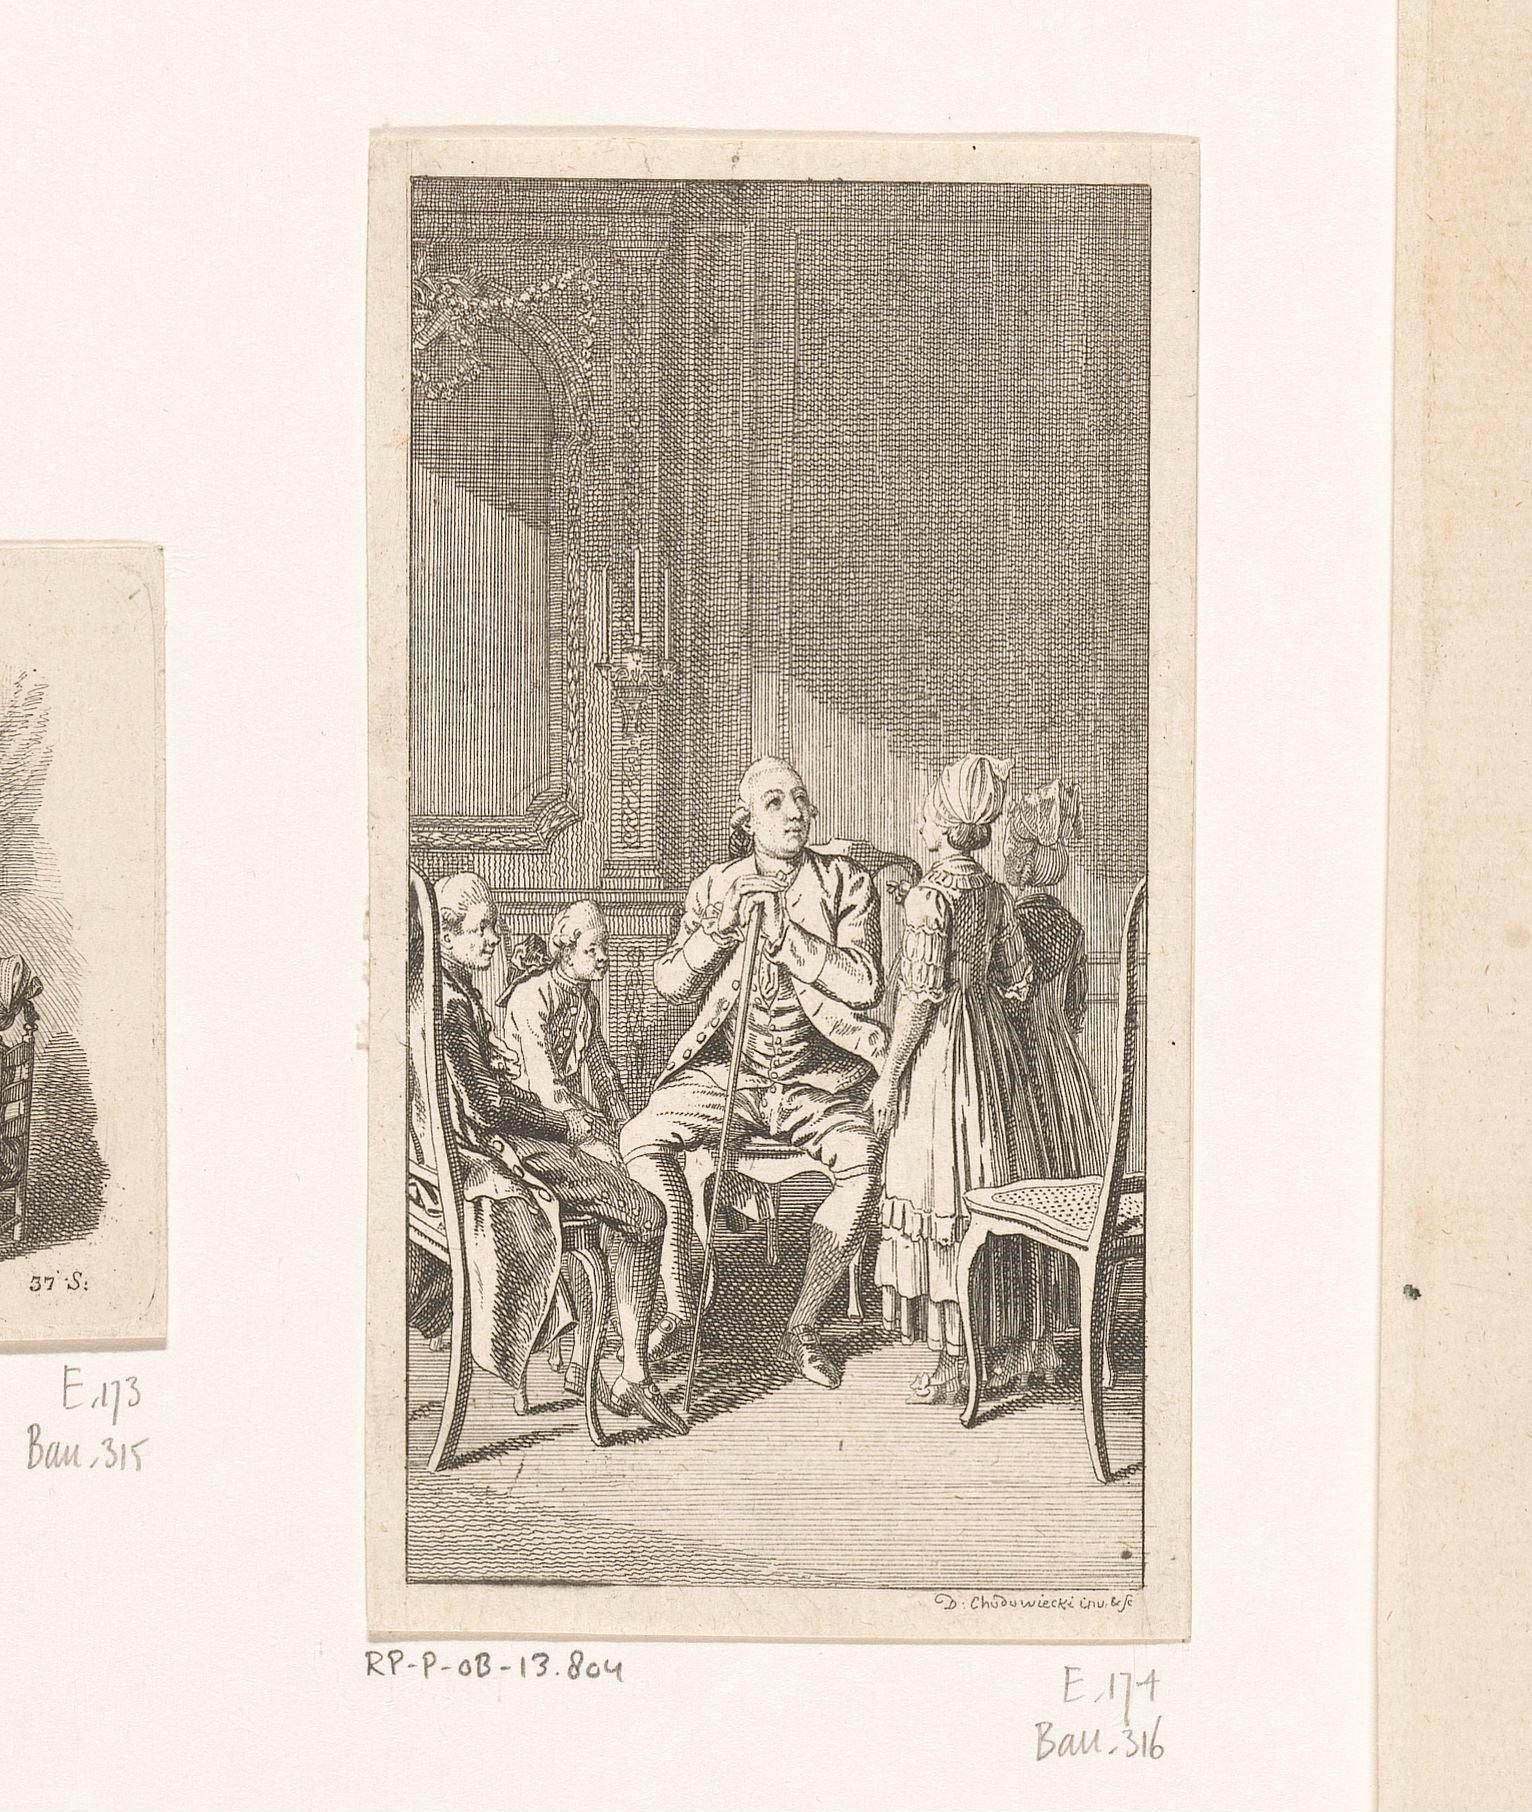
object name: print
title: Oom geeft een raadsel op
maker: daniel nikolaus chodowiecki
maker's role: draughtsman, print maker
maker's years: 1726-1801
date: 1776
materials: paper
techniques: etching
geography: berlin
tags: uncles, aunts (third degree family relationships), guessing games (children)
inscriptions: collector's mark: Lugt 2228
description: Een latere staat van deze prent is ook gebruikt in: Schummel, Johann Gottlieb. Kinderspiele und Gespräche. Leipzig: Siegfried Lebrecht Crusius, 1776-1778, 3 dln.